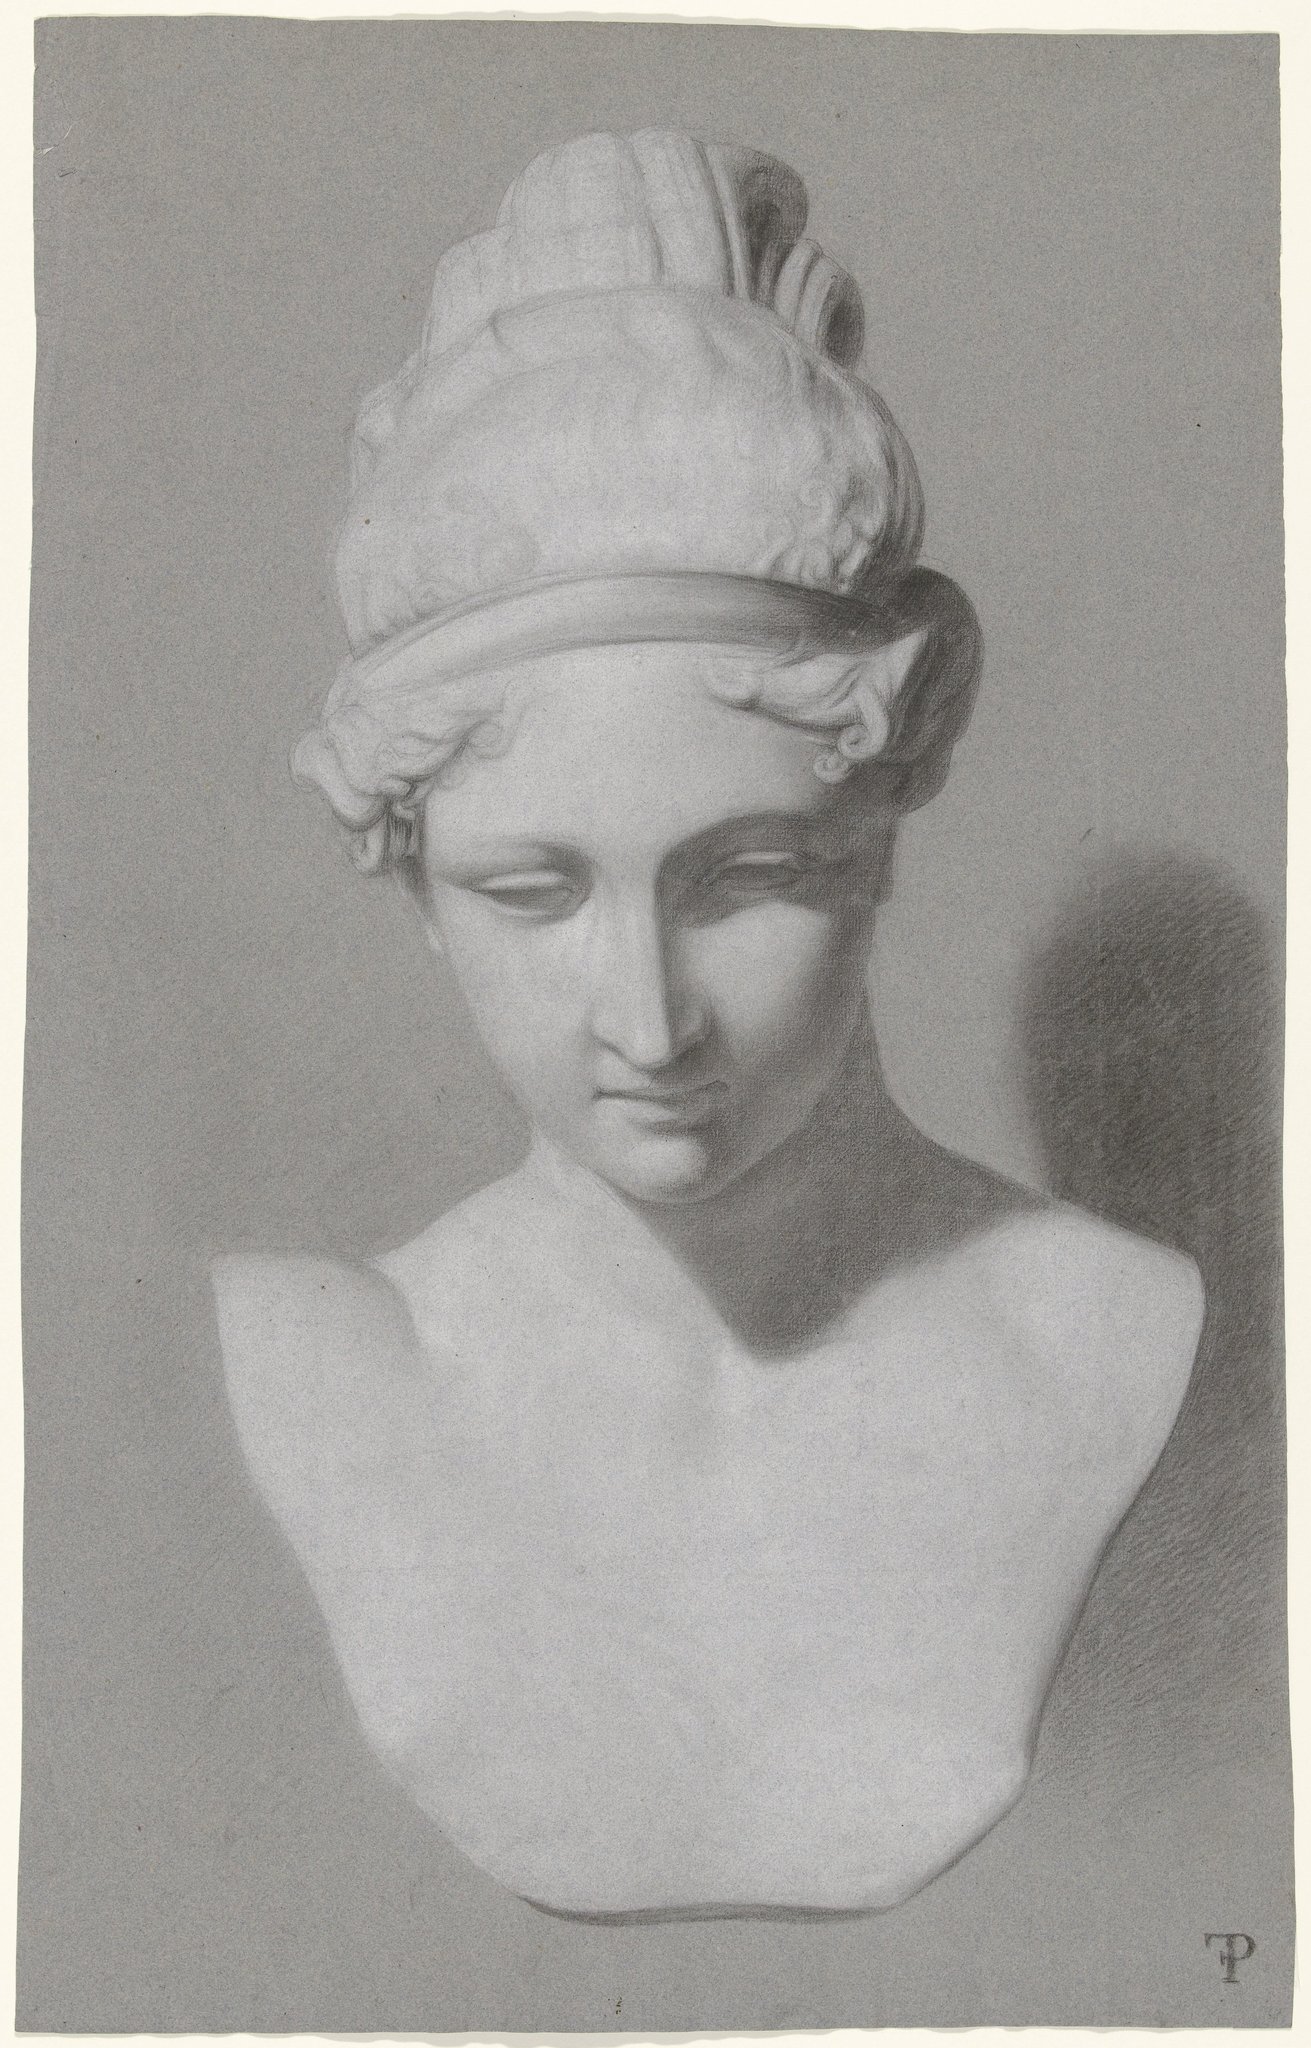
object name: drawing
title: Gipsmodel van een borstbeeld van een vrouw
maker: Anonymous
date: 1700-1800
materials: chalk, paper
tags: piece of sculpture, reproduction of a piece of sculpture